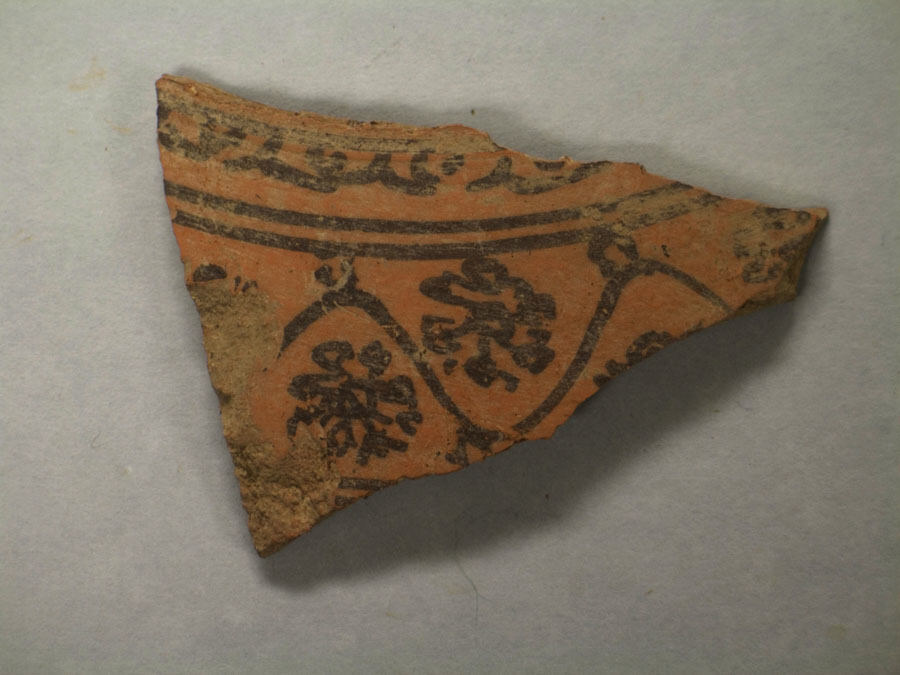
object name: shard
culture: pakistani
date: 301-500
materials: terracotta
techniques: painting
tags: gandhara